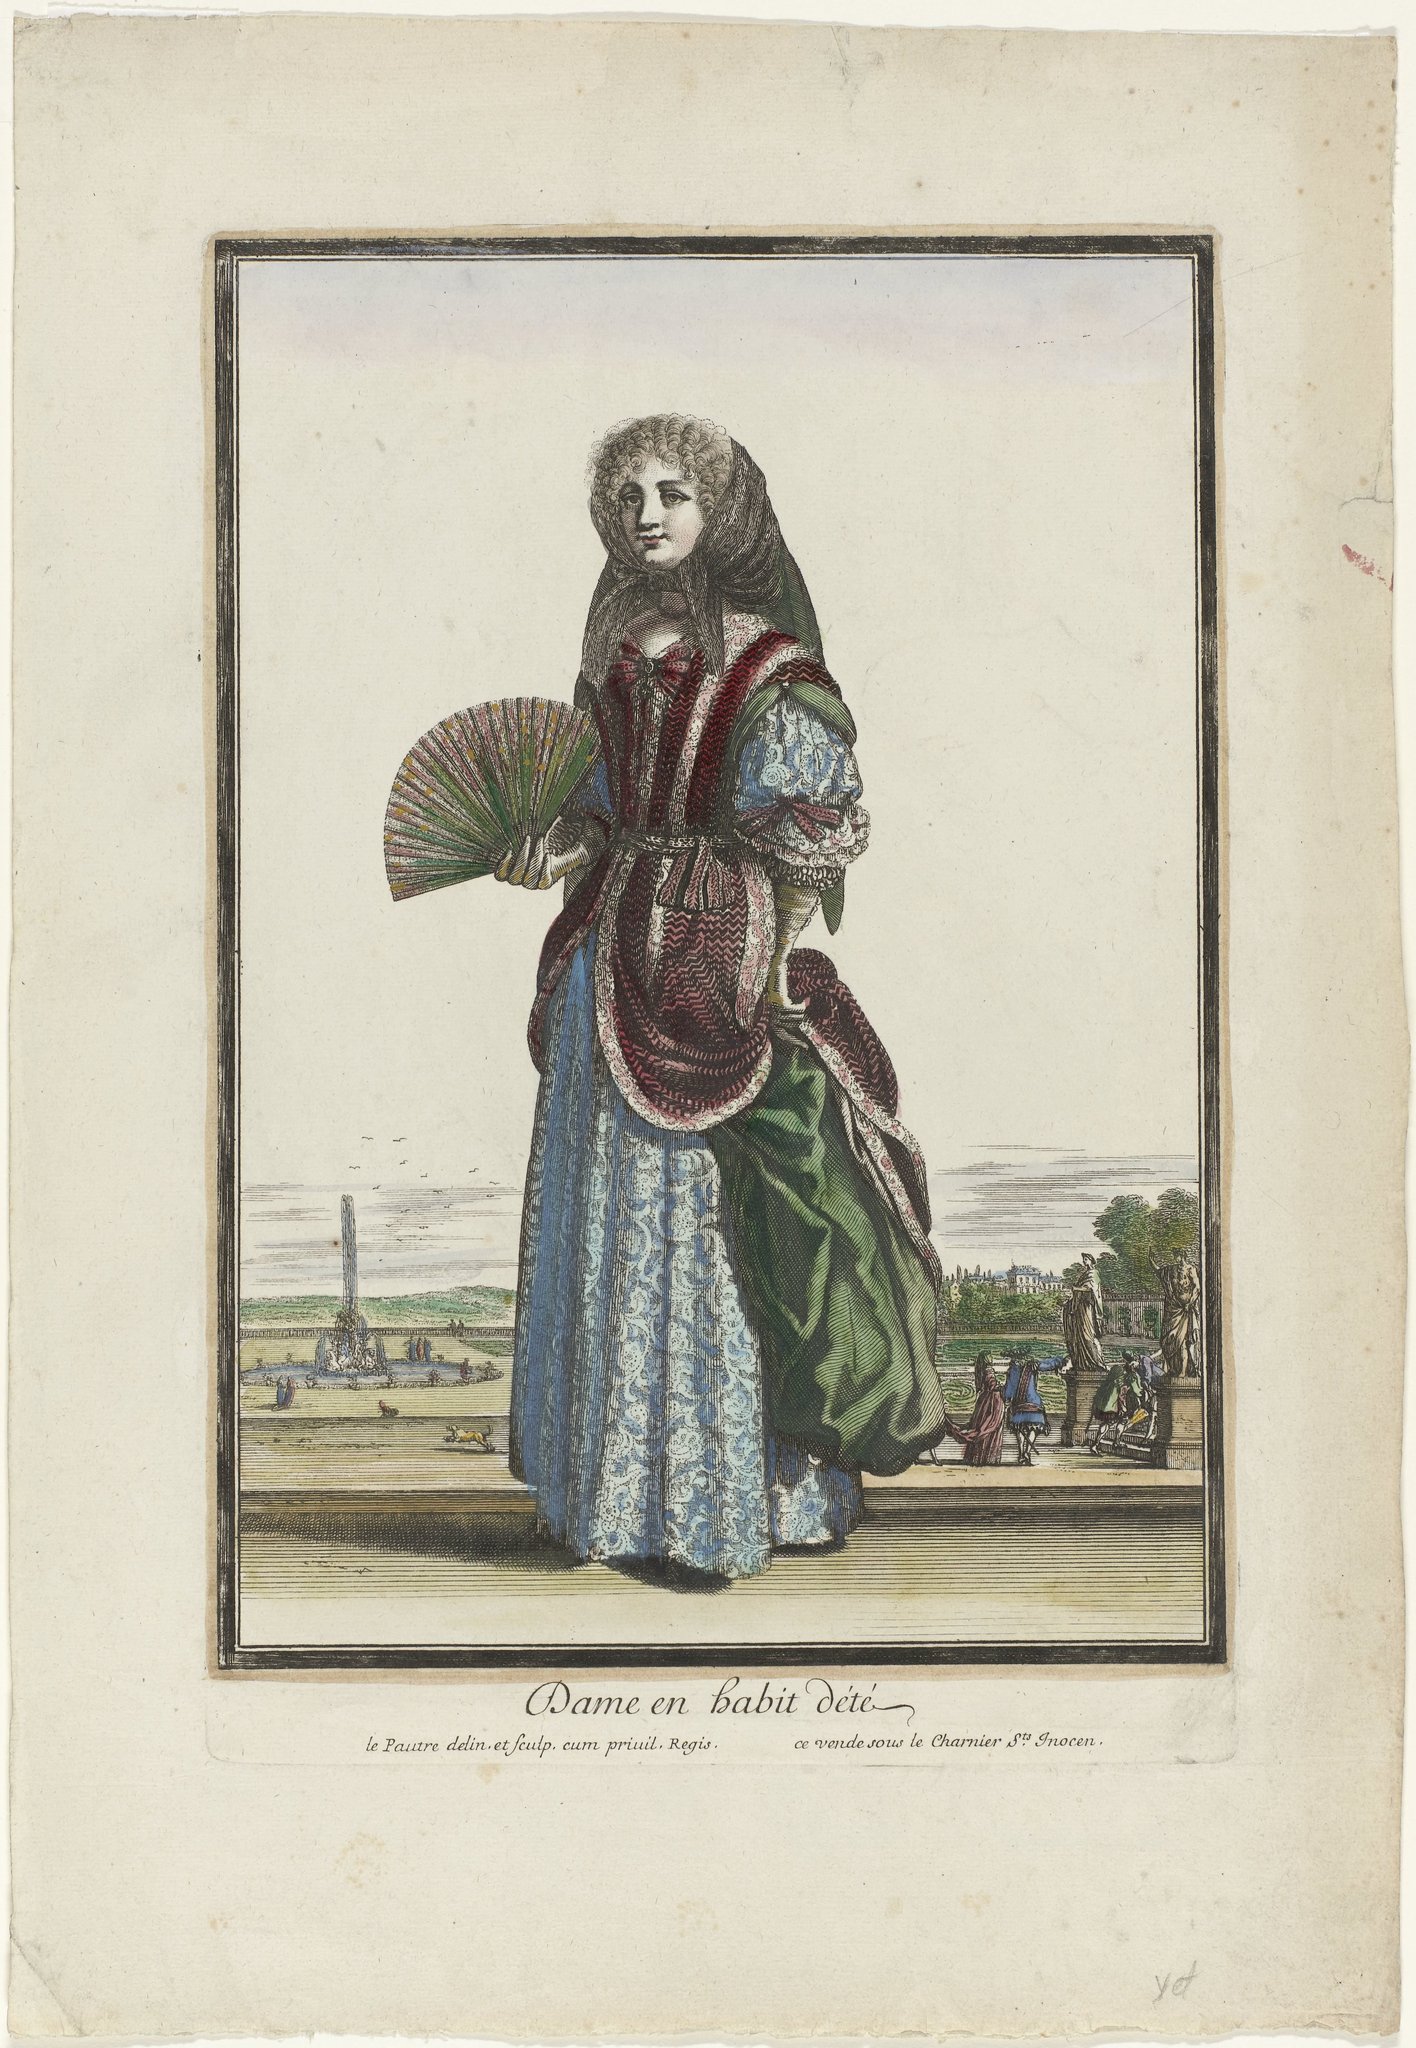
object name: costume print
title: Dame en habit d'été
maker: jean lepautre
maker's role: draughtsman, print maker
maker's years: 1618-1682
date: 1676-1678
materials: paper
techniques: engraving, hand coloring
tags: veil (+ women's clothes), styles of hairdress (hurluberlu) - aa - ~ women, fashion plates, skirt (+ women's clothes), gloves, mittens, etc. (+ women's clothes), dress, gown: manteau (+ women's clothes), sleeves (+ women's clothes)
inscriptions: address: ‘le Pautre delin. et sculp.cum privil.Regis. ce vend sous le Charnier Ste Inocen.’, title: ‘Dame en habit d été’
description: Vrouw in elegante zomerkleren, staand voor een park met fontein. Zij is gekleed in een manteau met rok en bijpassende mouwen. Over het "hurluberlu") kapsel een hoofddoek, afhangend op de rug. Een vouwwaaier in de rechterhand. De prent maakt deel uit van de tweede serie van: Suite de Costumes gegraveerd door Jean le Pautre (gedeeltelijk voor Le Nouveau Mercure Galant), bestaand uit 12 prenten. Suite de Costumes bestaat uit drie series van in totaal 40 prenten.